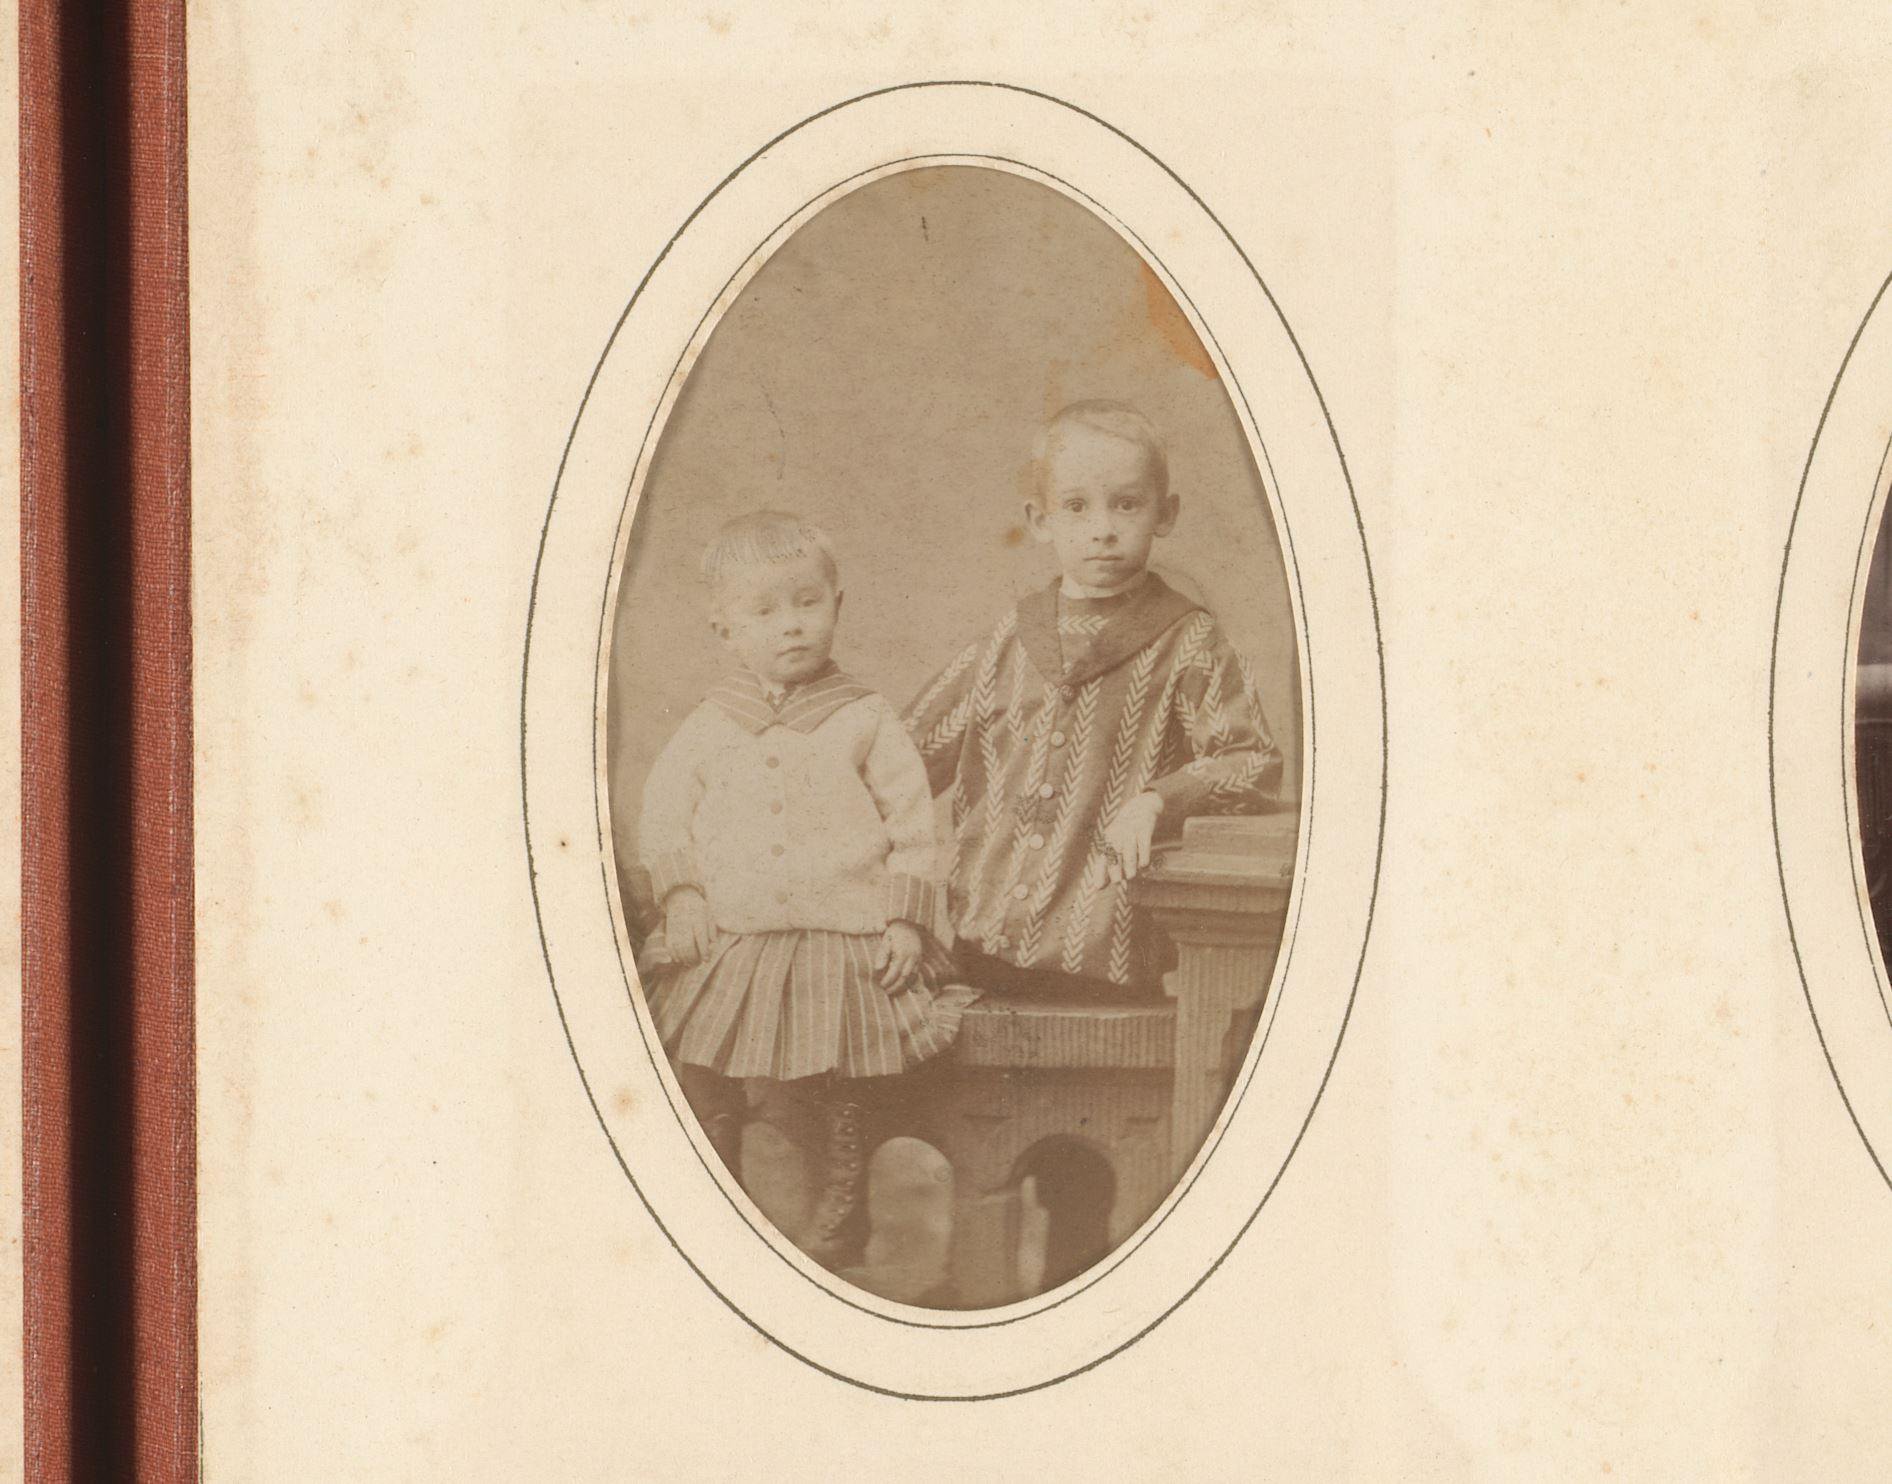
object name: photograph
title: Portret van twee kinderen bij een balustrade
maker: albert greiner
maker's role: fotograaf, fotostudio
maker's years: 1833-1890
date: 1874-1887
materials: cardboard, photographic support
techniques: albumen print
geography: amsterdam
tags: historical persons - bb - woman, boy (child between toddler and youth), historical persons, balustrade, toddler (female)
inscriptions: inscription: ‘ALBERT GREINER/ KON. NED. HOF-PHOTOGRAAF/ AMSTERDAM/ NIEUWENDIJK 89./ Specialiteit in Vergrootingen.’